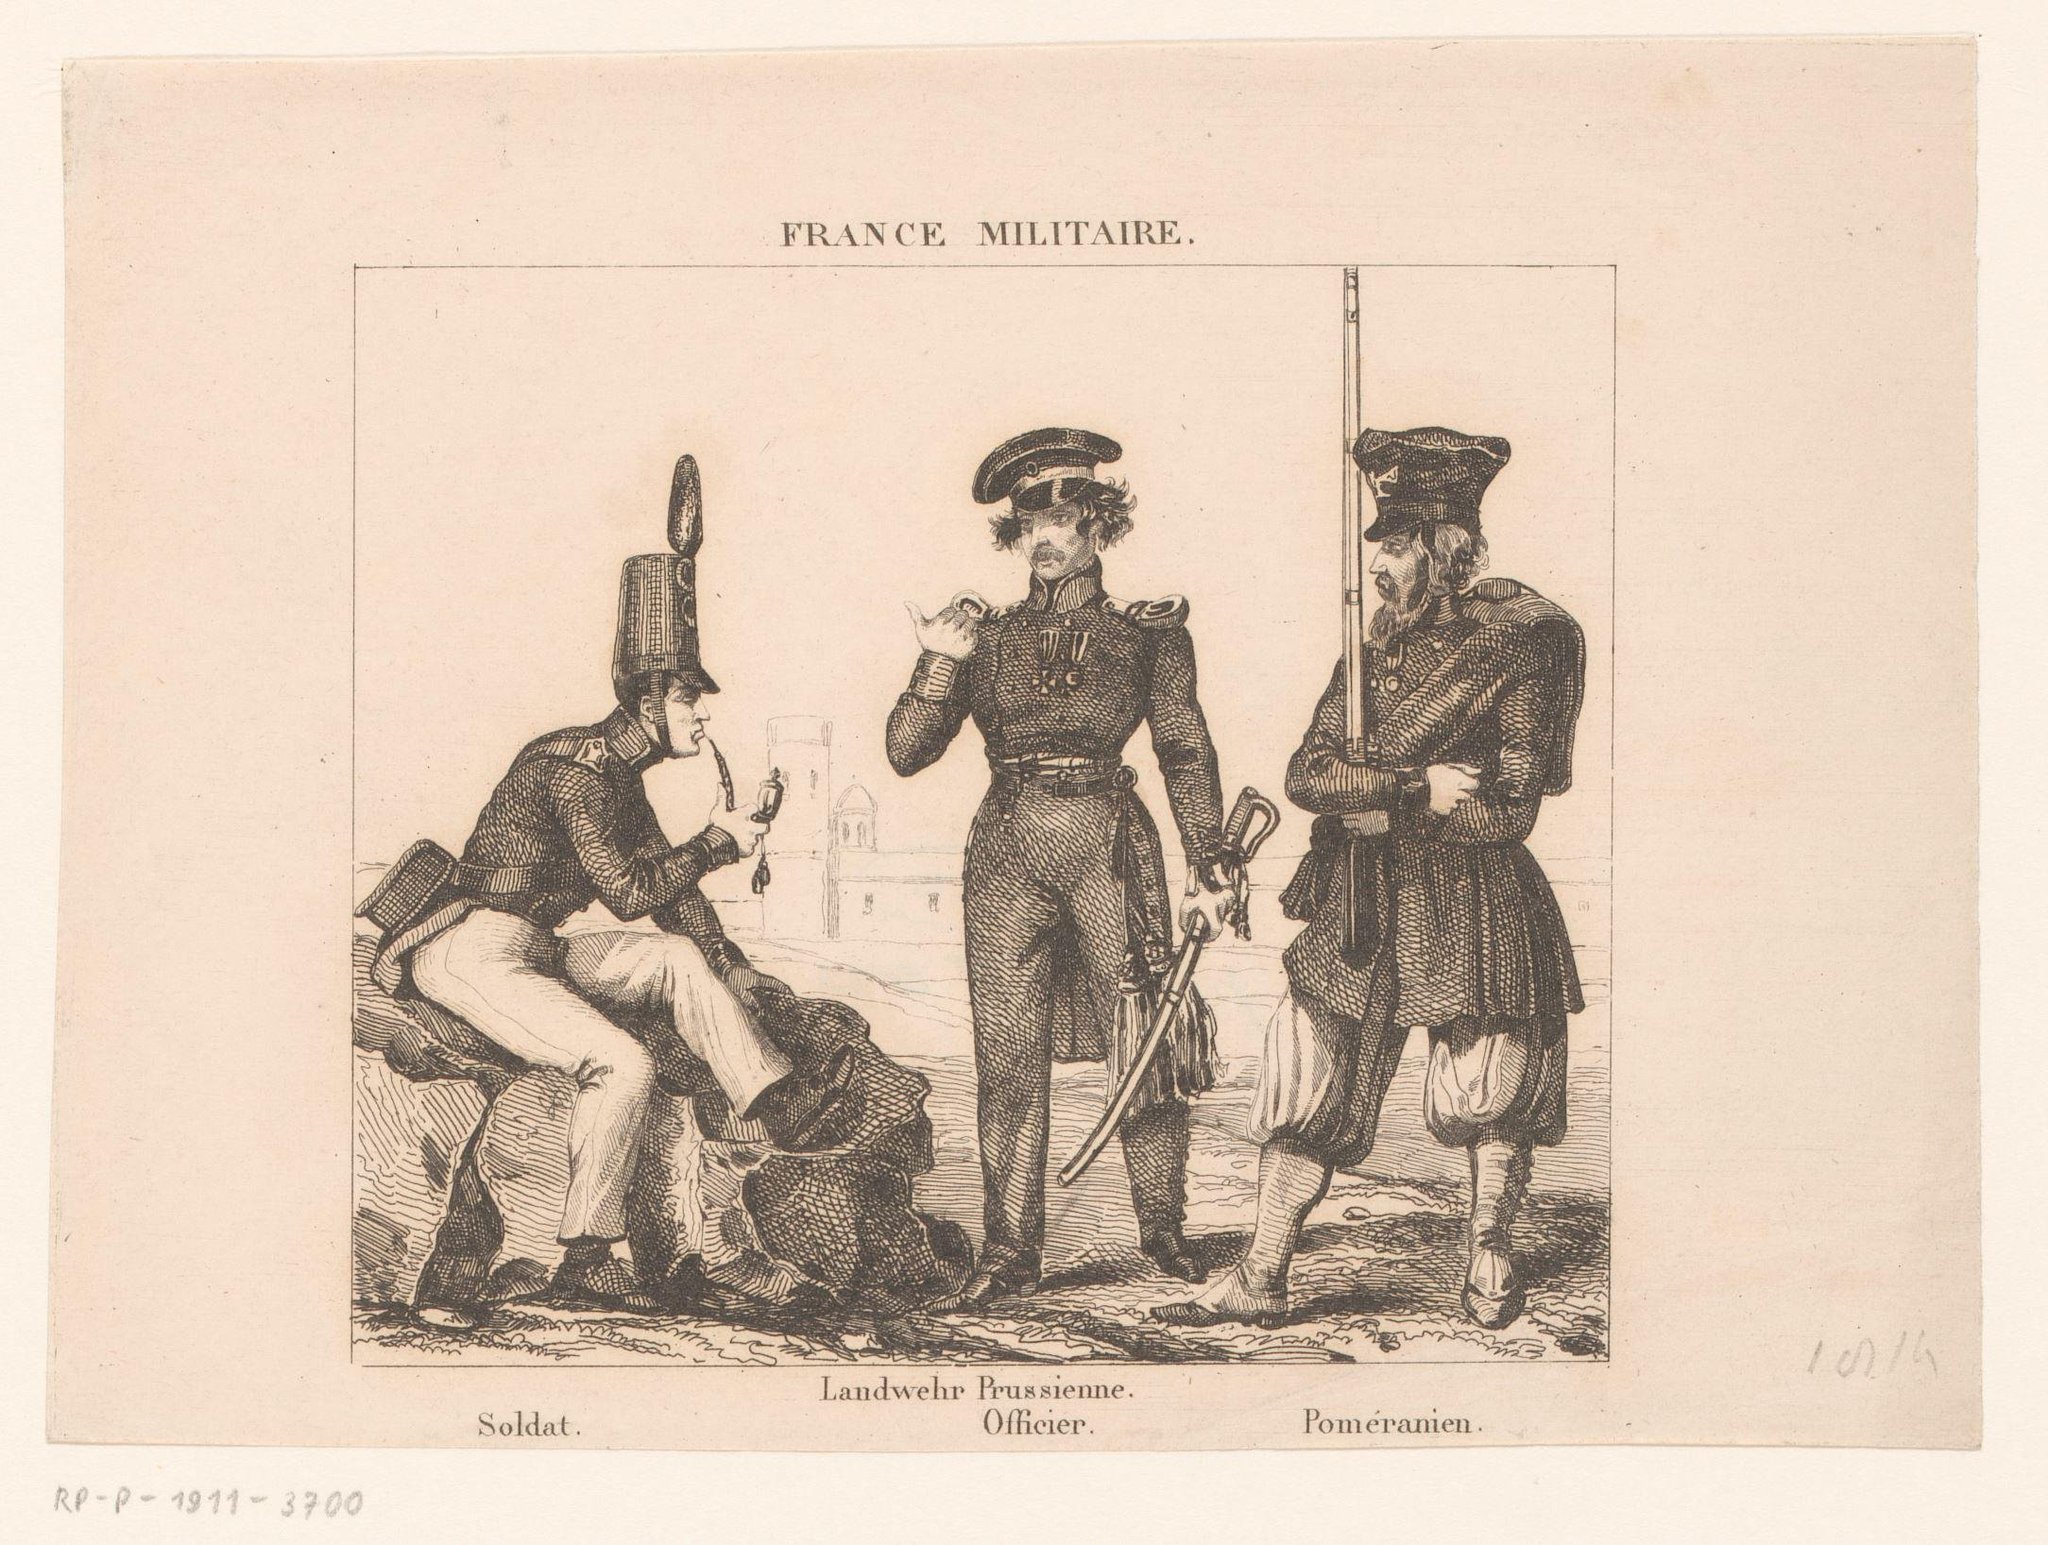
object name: print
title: France militaire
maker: alexandre lacauchie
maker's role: painter, print maker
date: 1830-1860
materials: paper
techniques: etching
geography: france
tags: private soldier, officer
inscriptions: collector's mark: Lugt 2228